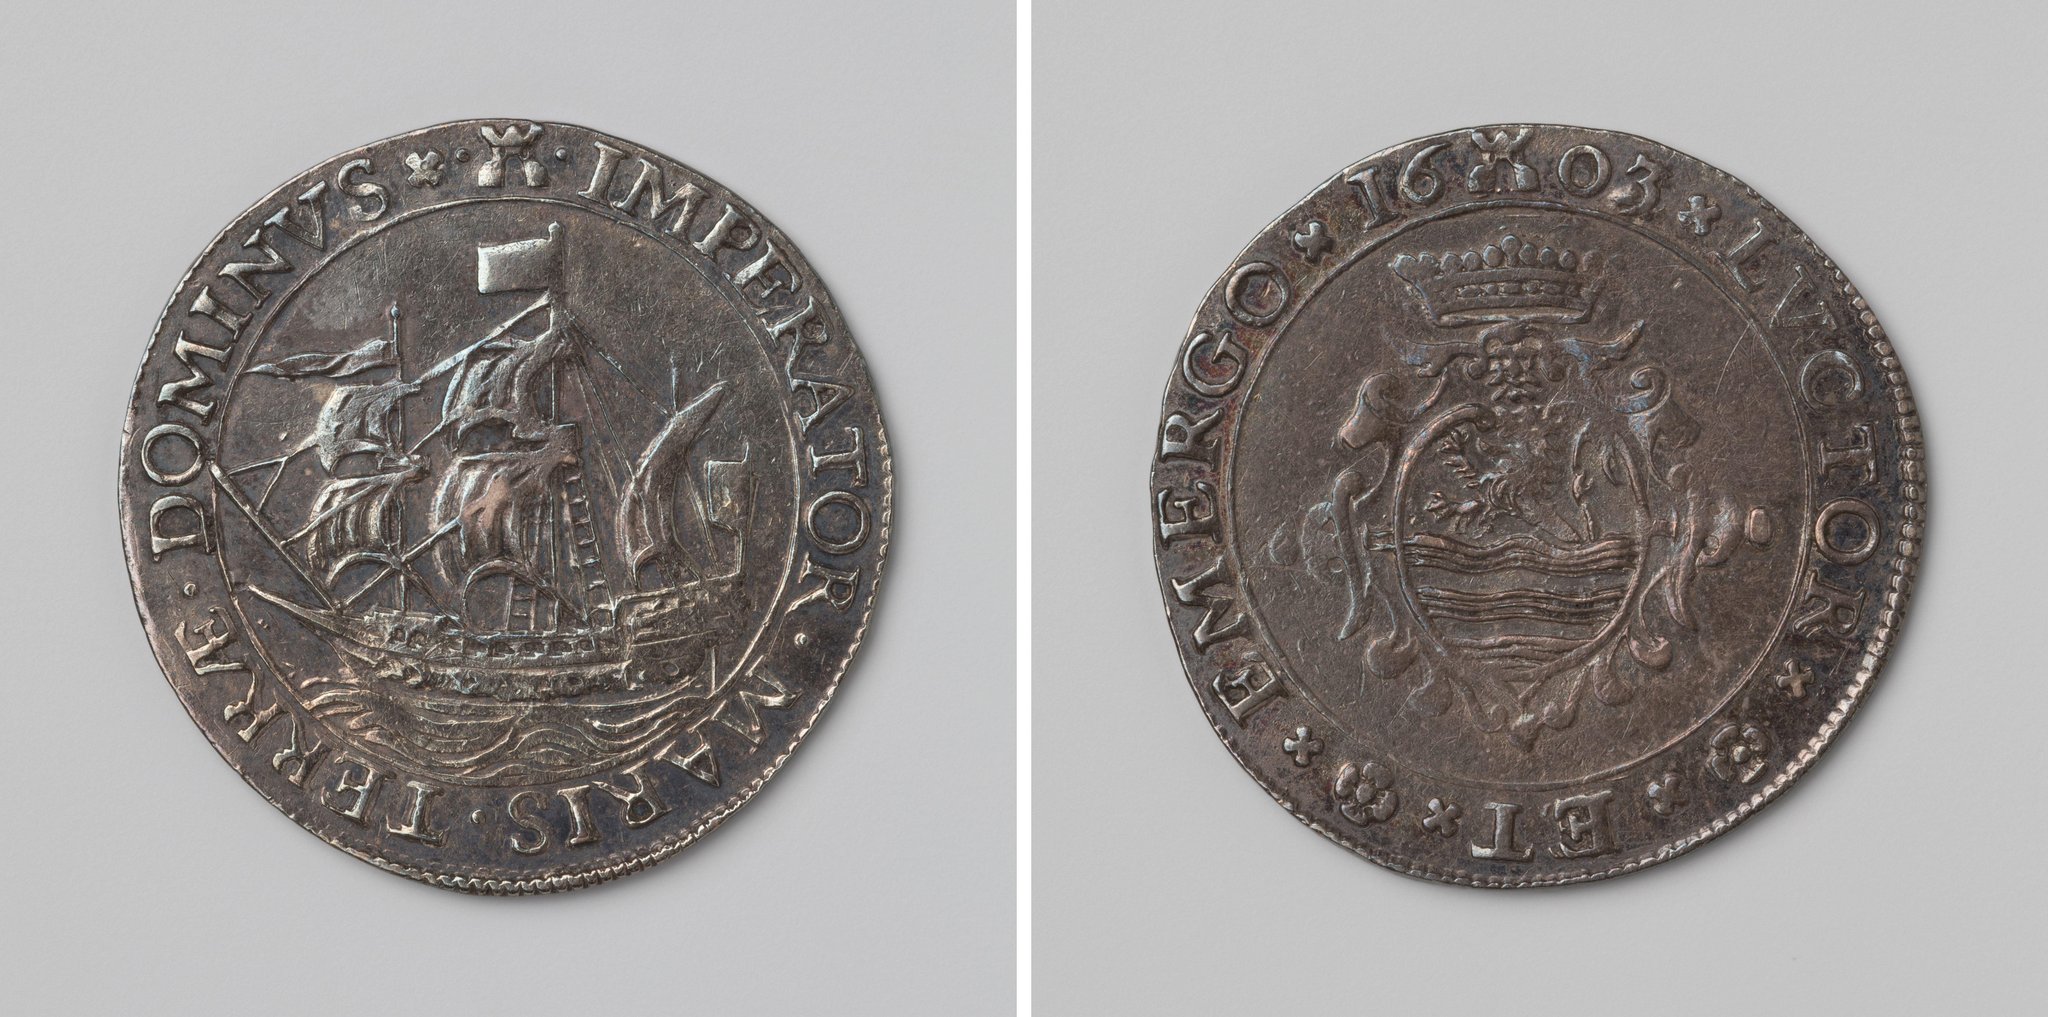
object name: jeton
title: Bloei van de zeevaart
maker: Anonymous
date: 1603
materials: silver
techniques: striking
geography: middelburg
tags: zeeland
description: Zilveren penning. Voorzijde: driemaster op zee binnen omschrift. Keerzijde: gekroond wapenschild in cartouche binnen omschrift